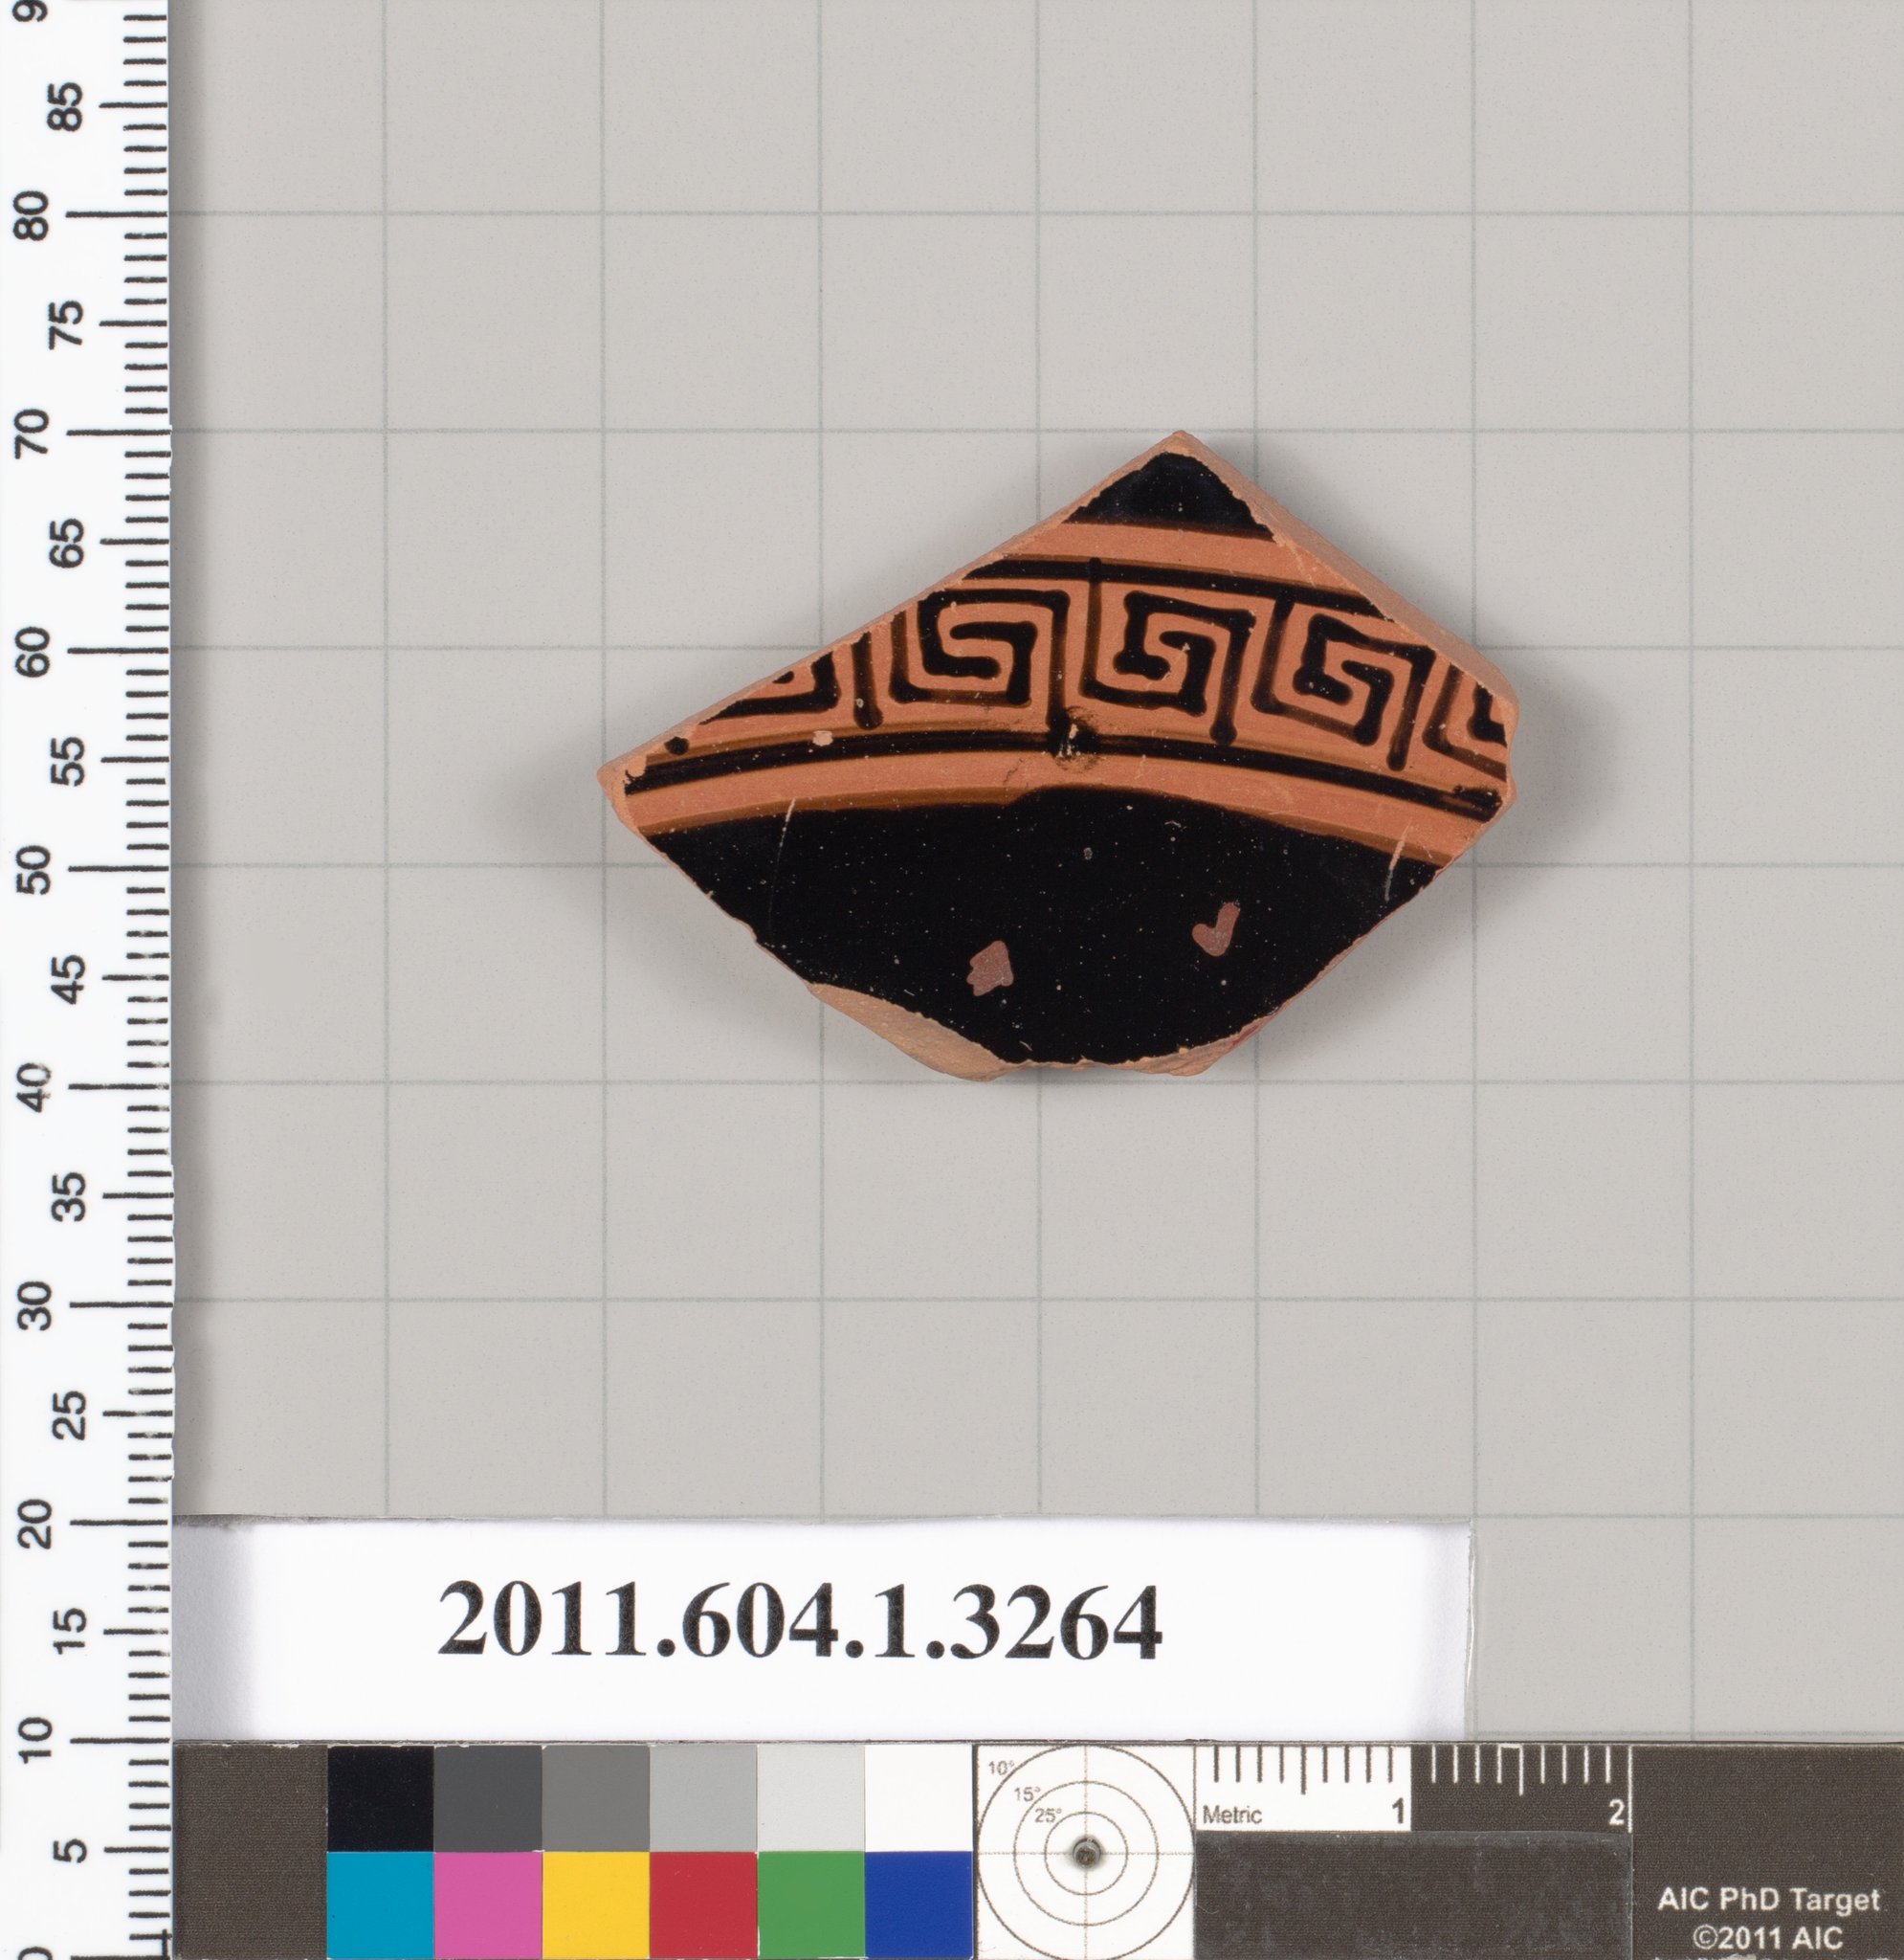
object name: kylix fragment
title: Terracotta fragment of a kylix (drinking cup)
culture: greek, attic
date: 490-480 BCE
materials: terracotta